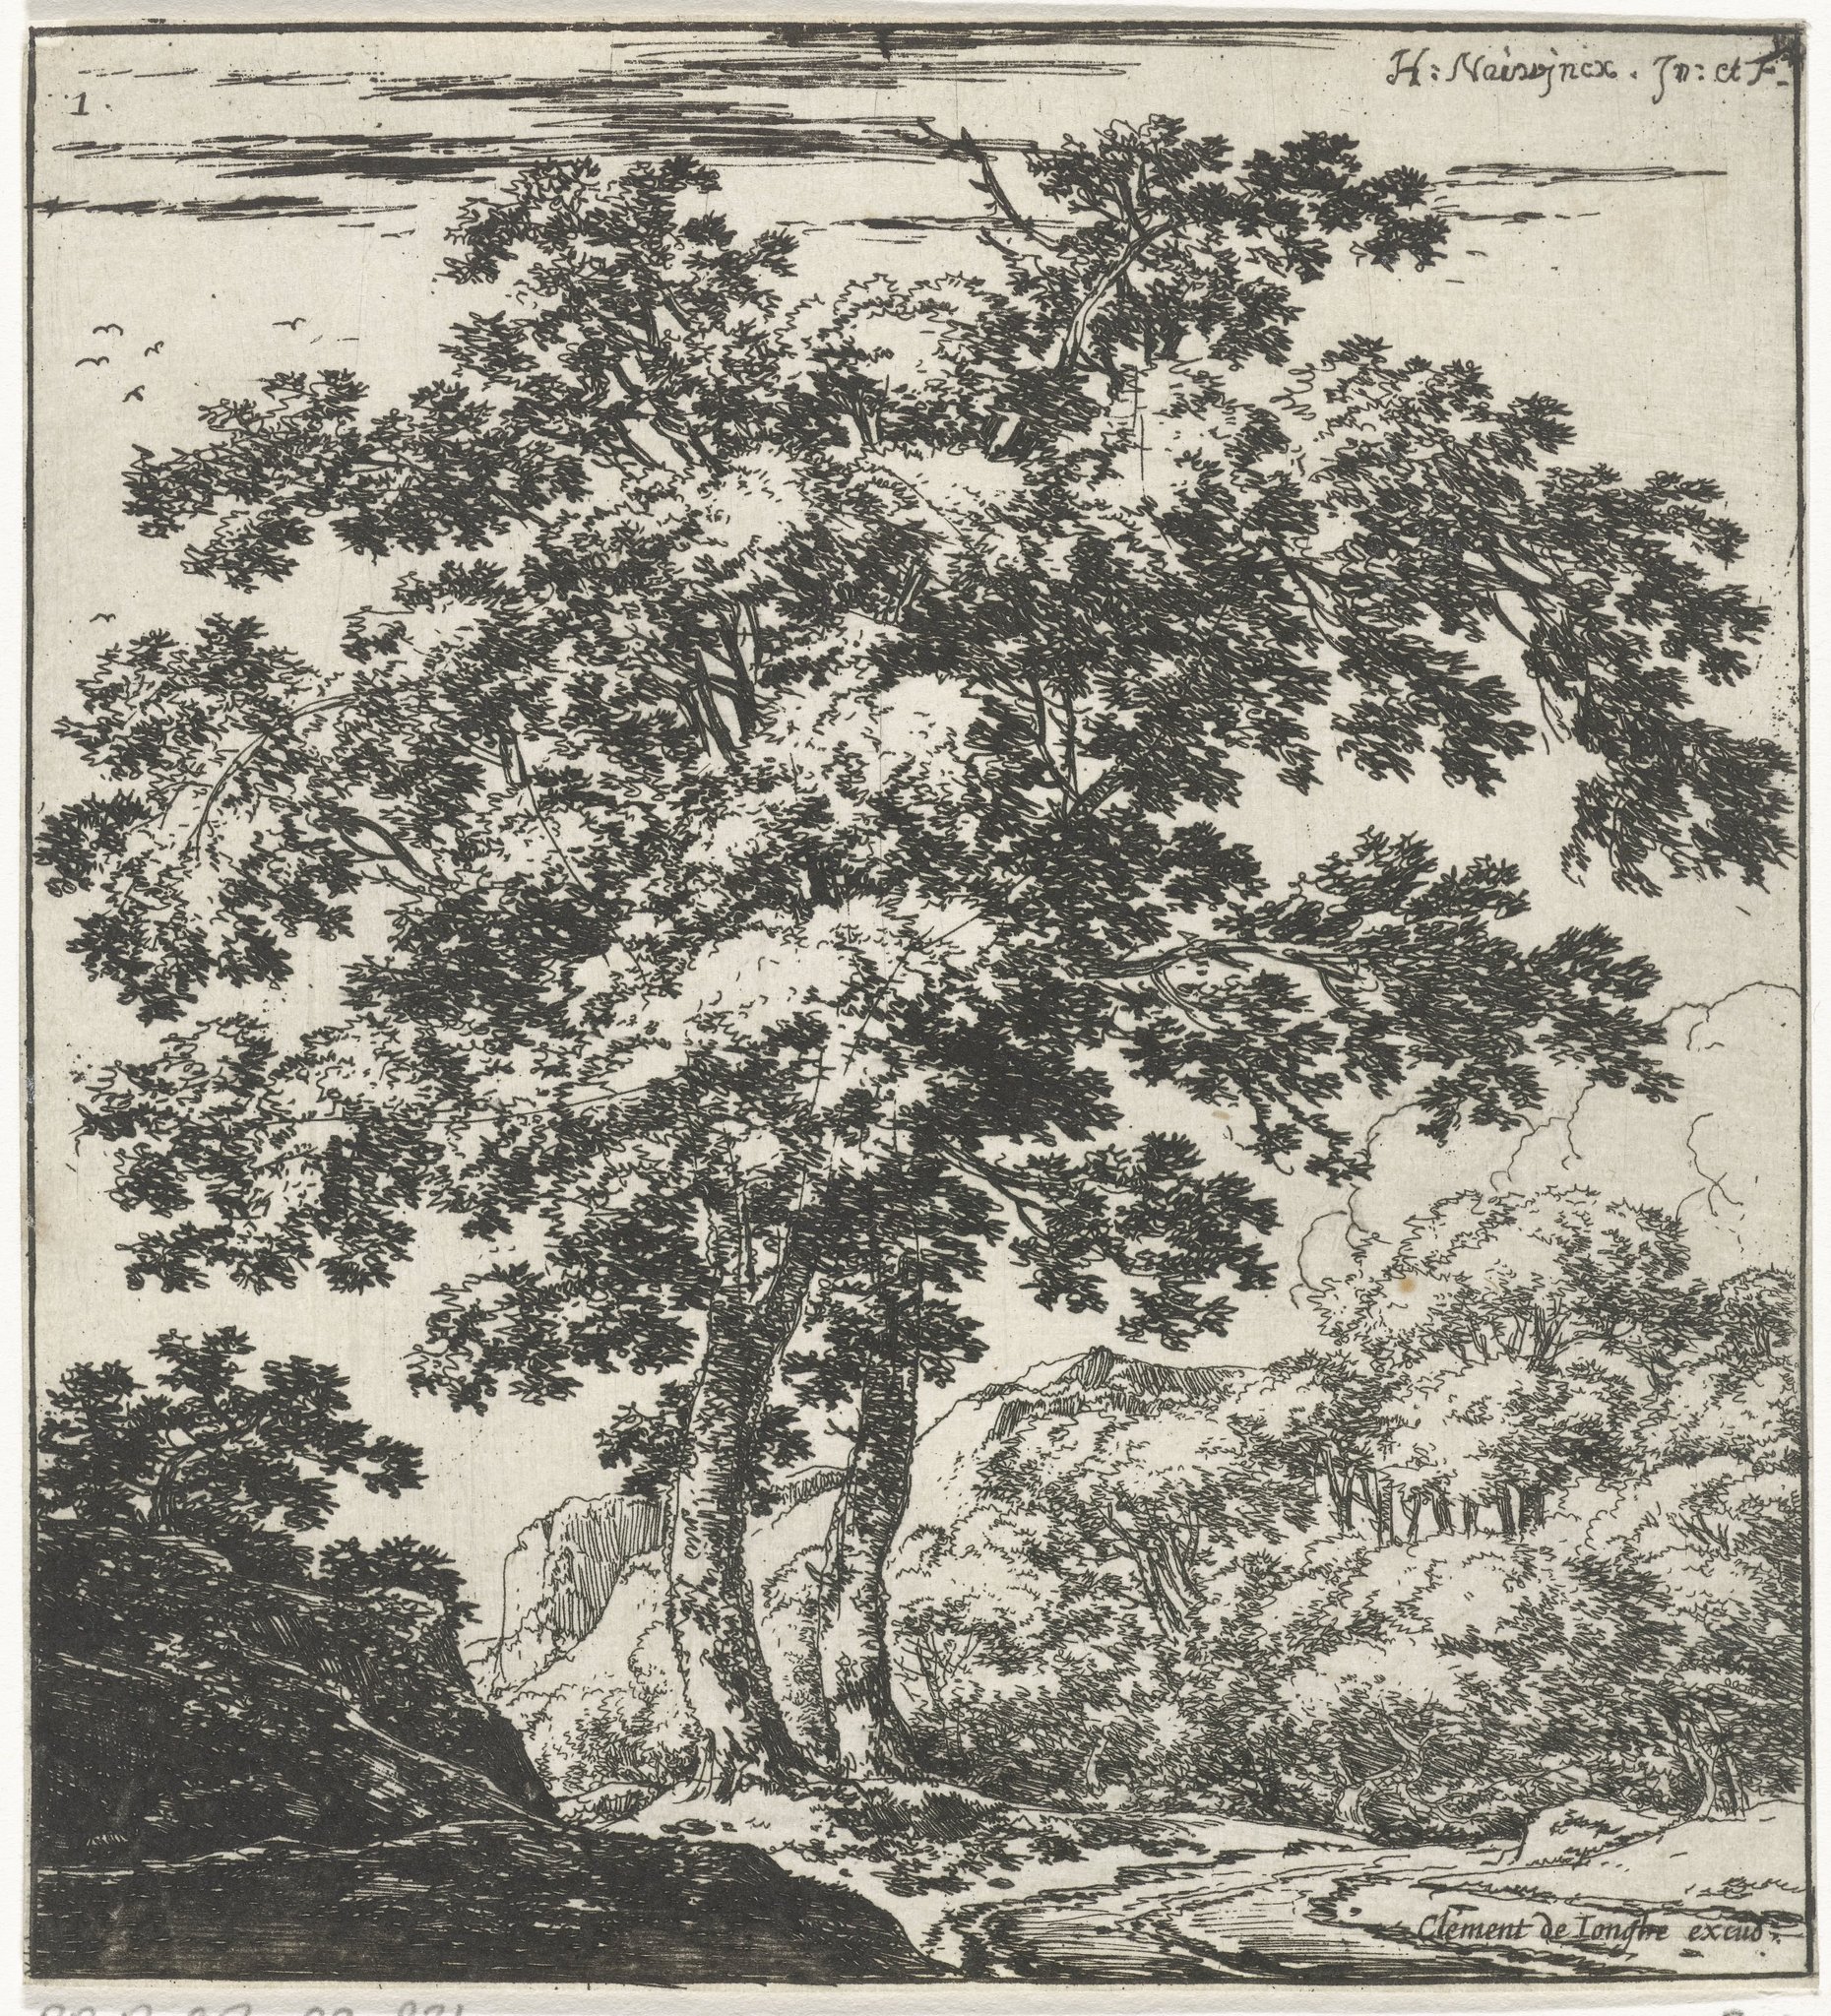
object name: print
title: Serie 2: Landschappen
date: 1633-1670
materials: paper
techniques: etching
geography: amsterdam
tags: trees, forest, wood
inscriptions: collector's mark: Lugt 240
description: Twee grote bomen, rechts een weg, op de achtergrond bomen.